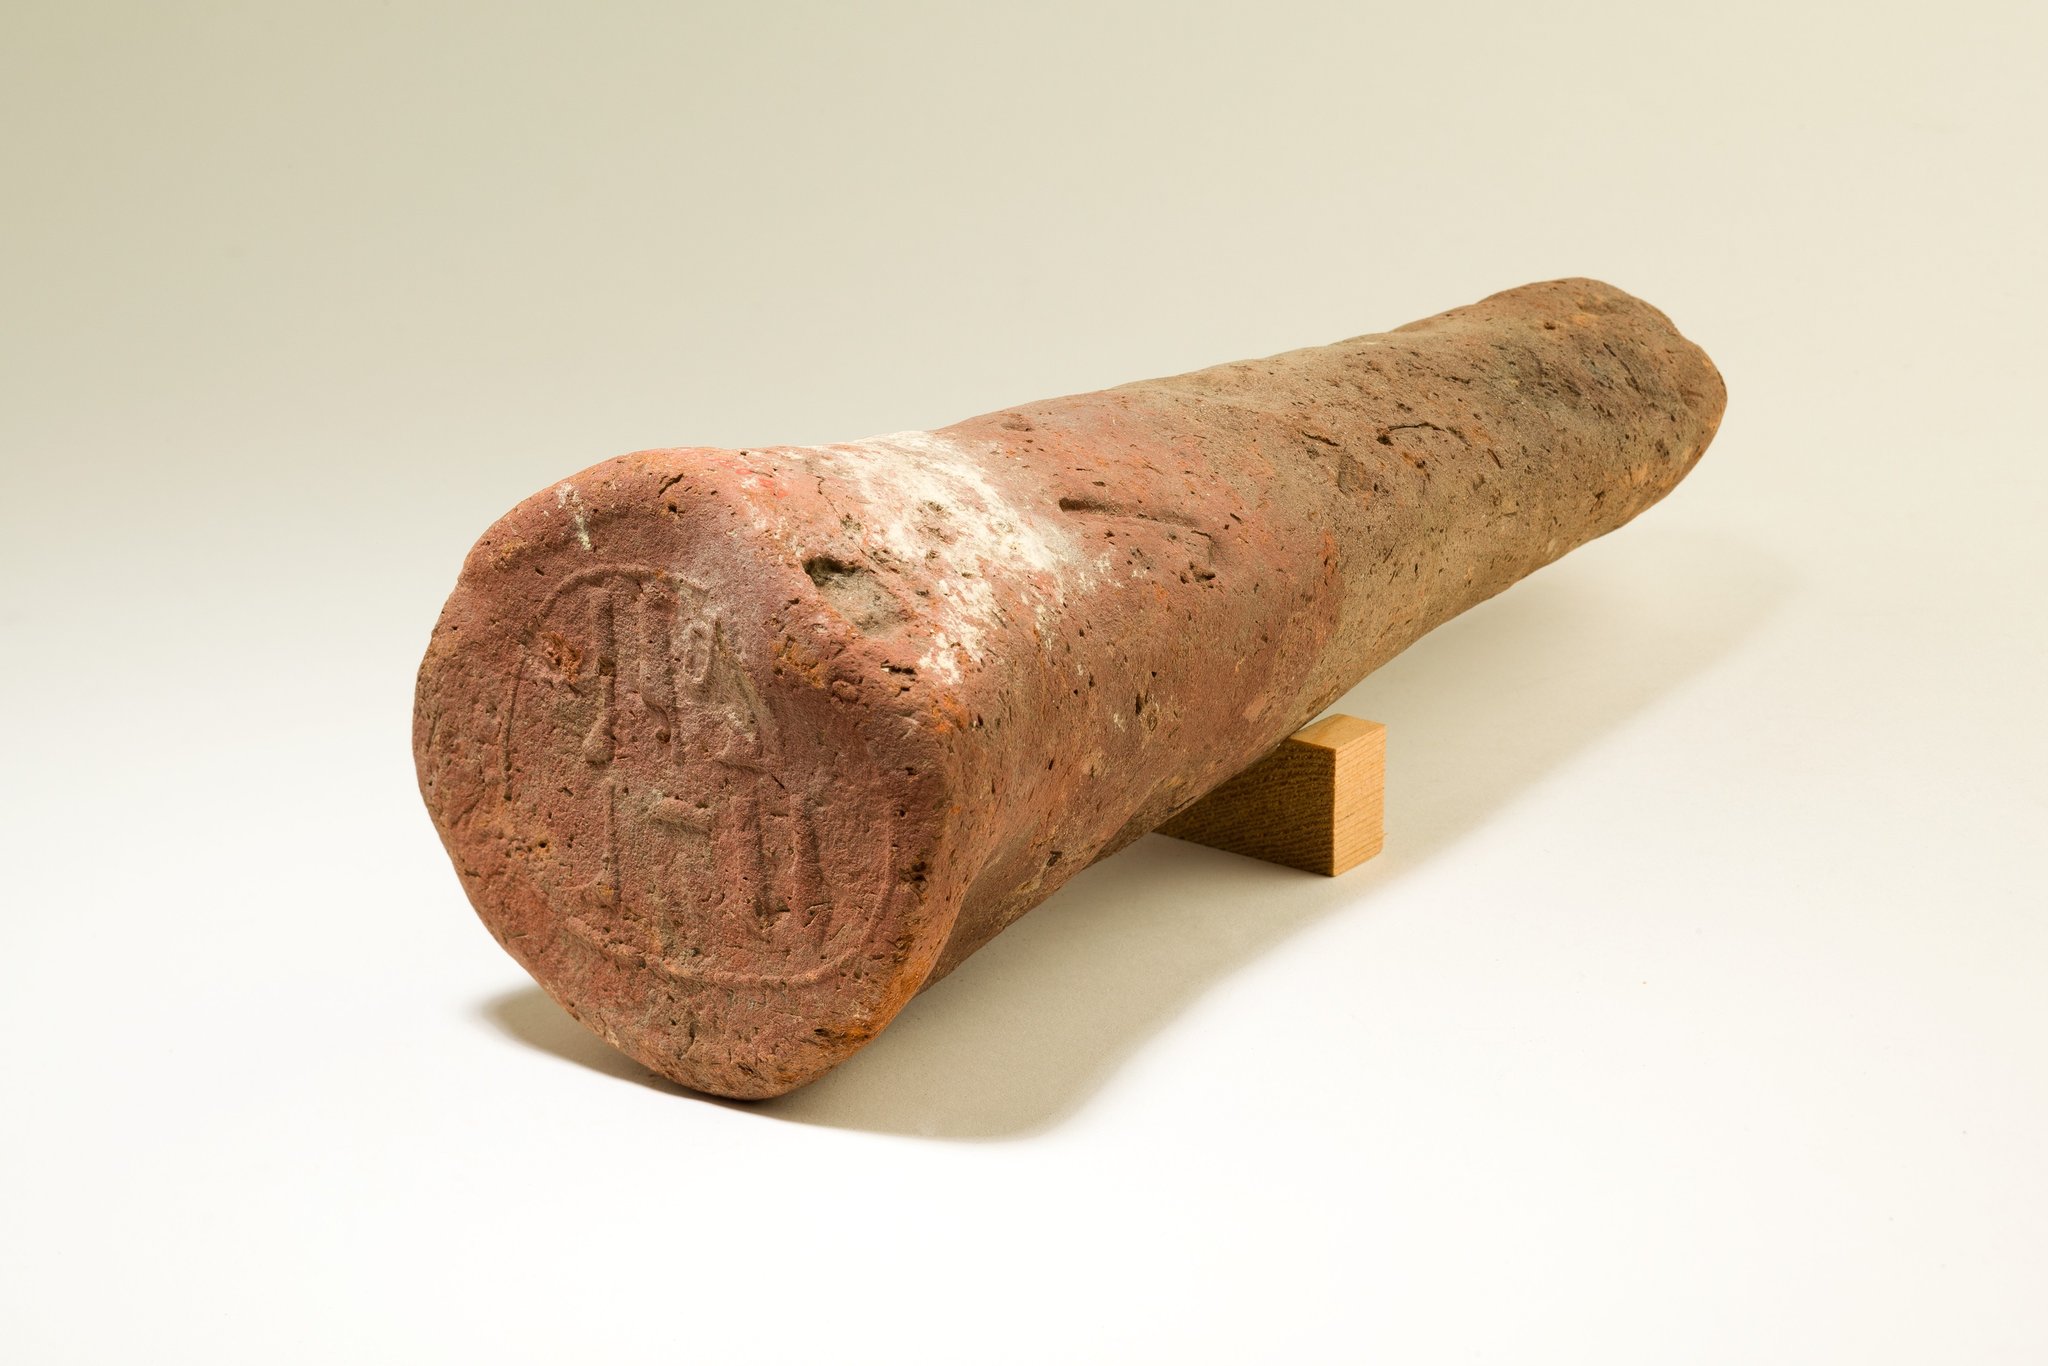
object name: cone, circular impression, ibety, herald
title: Funerary Cone of the Herald Ibety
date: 1550-1295 BCE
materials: pottery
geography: egypt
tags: hieroglyphs